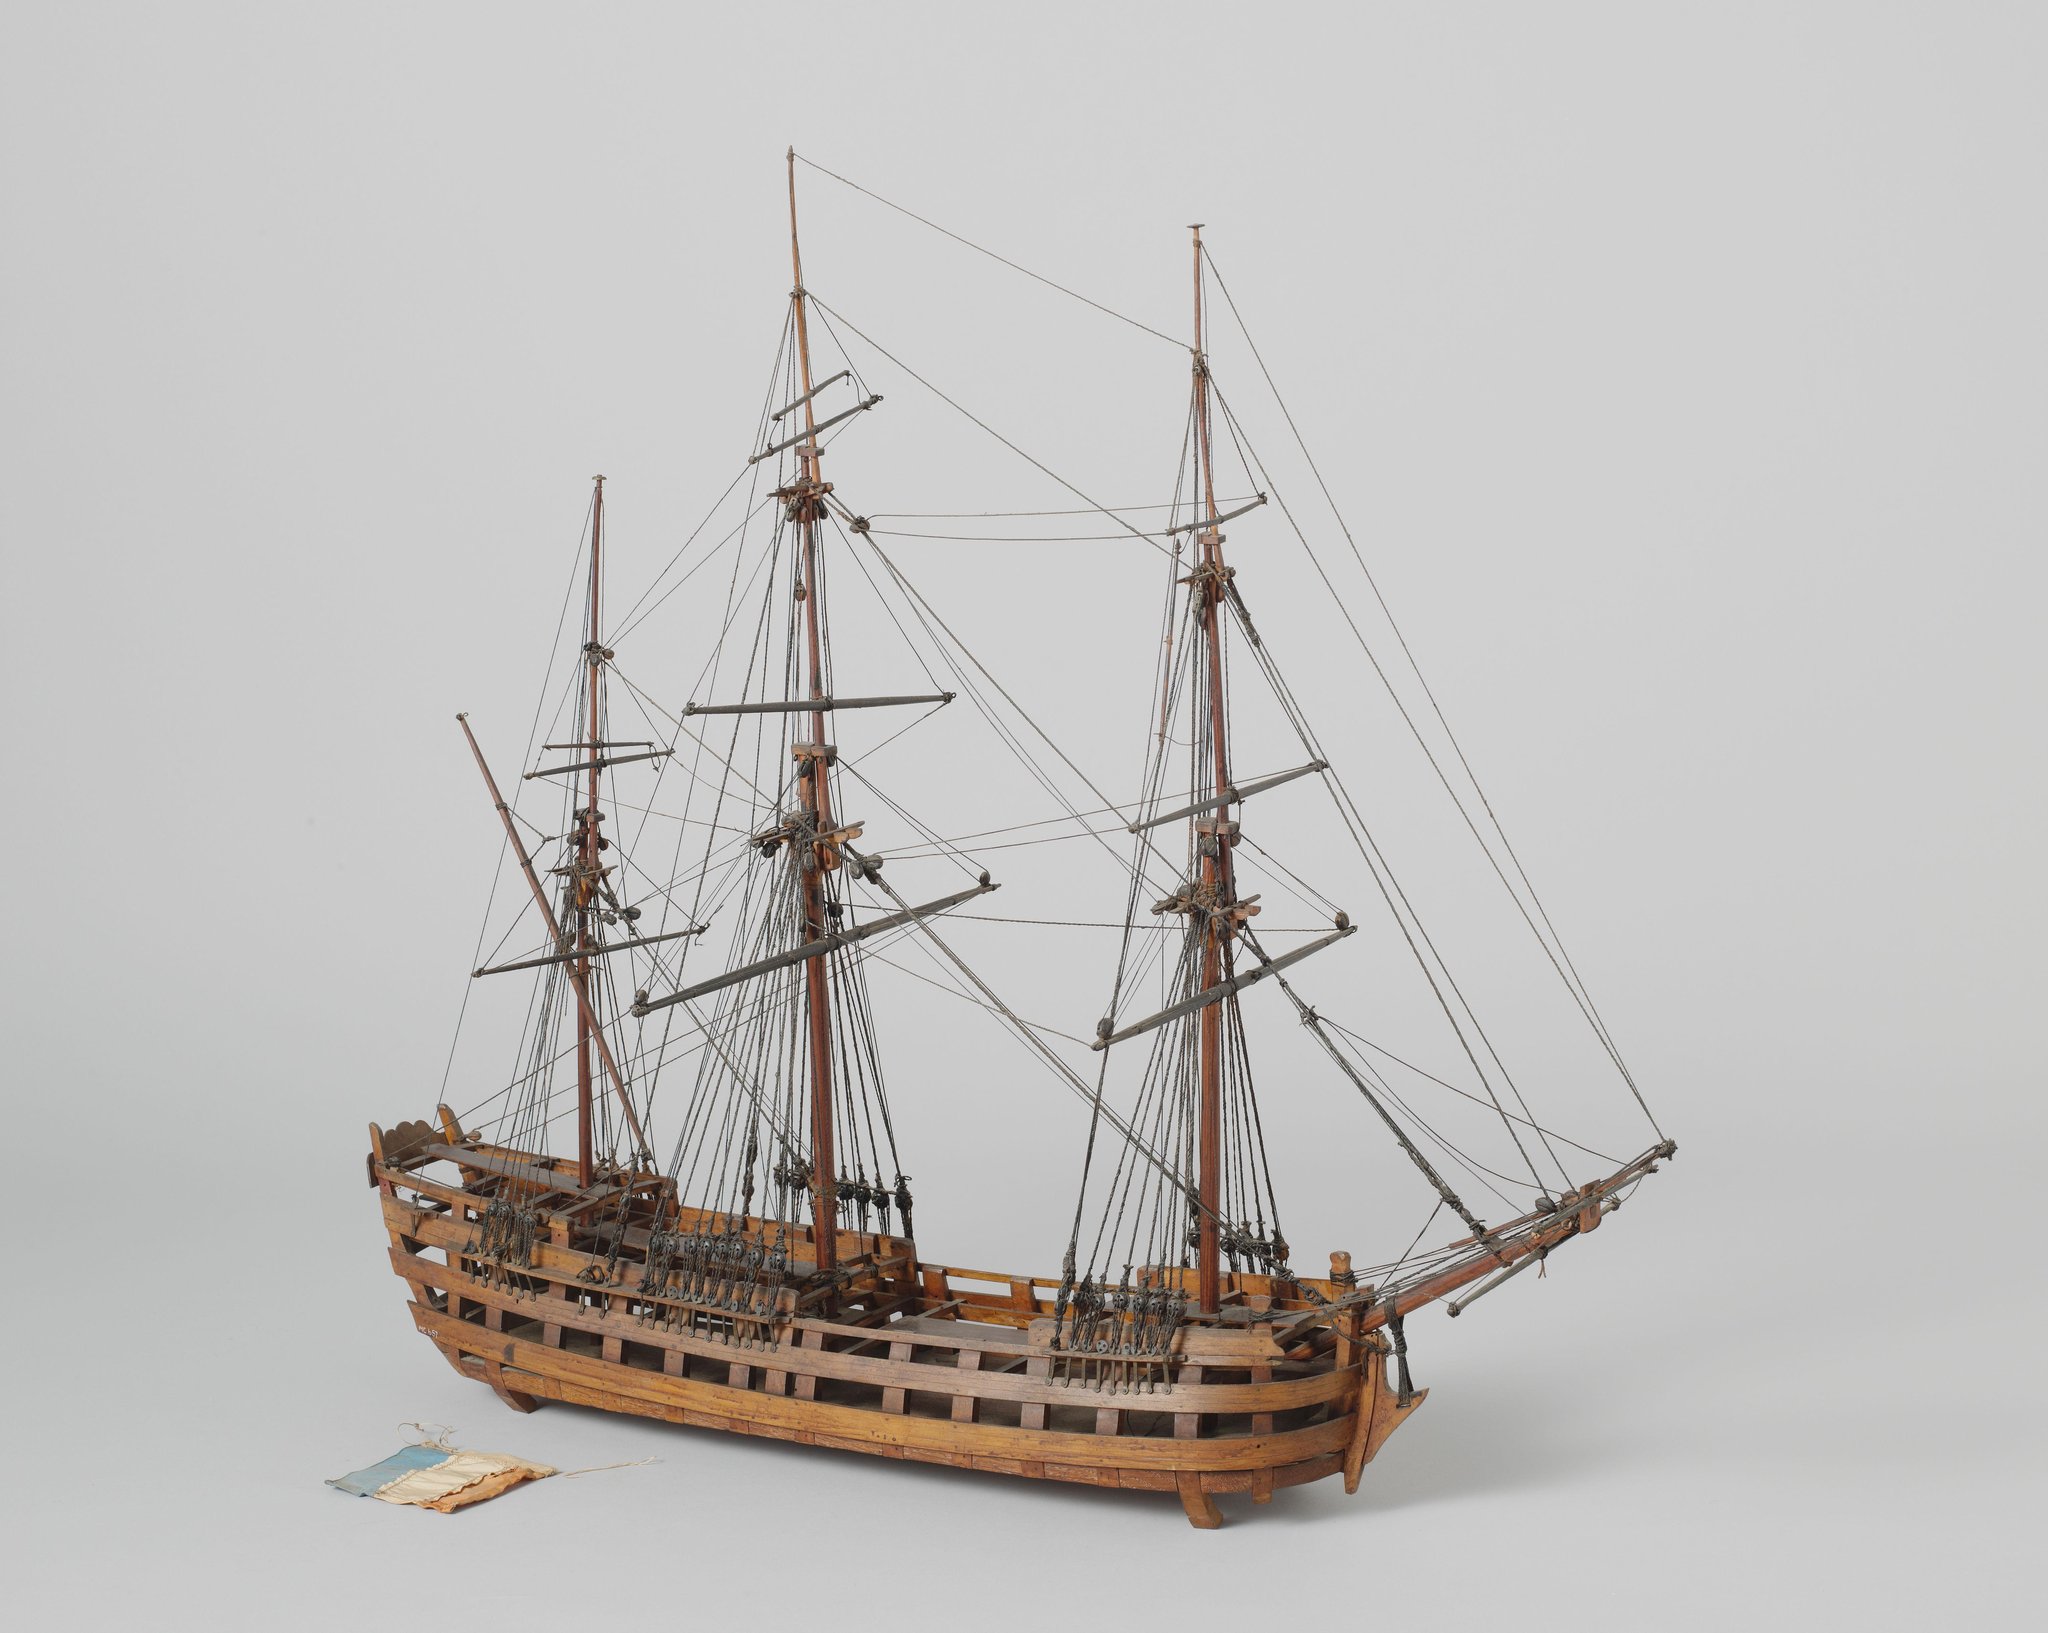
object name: ship model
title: Model of a Three-Masted Ship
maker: Anonymous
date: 1780-1820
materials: brass, fiber, wood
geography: netherlands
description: Getuigd waterlijn- en constructiemodel van een driemaster. De romp heeft geen huid en bestaat slechts uit de voornaamste inhouten. Het model heeft vier niveau's: onderdek, hoofddek, bovendek (halfdek en bak), en bovencampanje, geen van alle gesloten. Achterschip met gewrongen spiegel, hol wulf, geen details van hek behalve de constructie, geen zijgalerijen. De zeeg loopt een weinig op naar beiden uiteinden, twee barkhouten en één reehout. Het model demonstreert voornamelijk het driemasttuig zonder zeilen, voorzien van staand en lopend want; vermeldenswaard zijn de doorlopende grote en bezaansrust, en de bezaansroede.